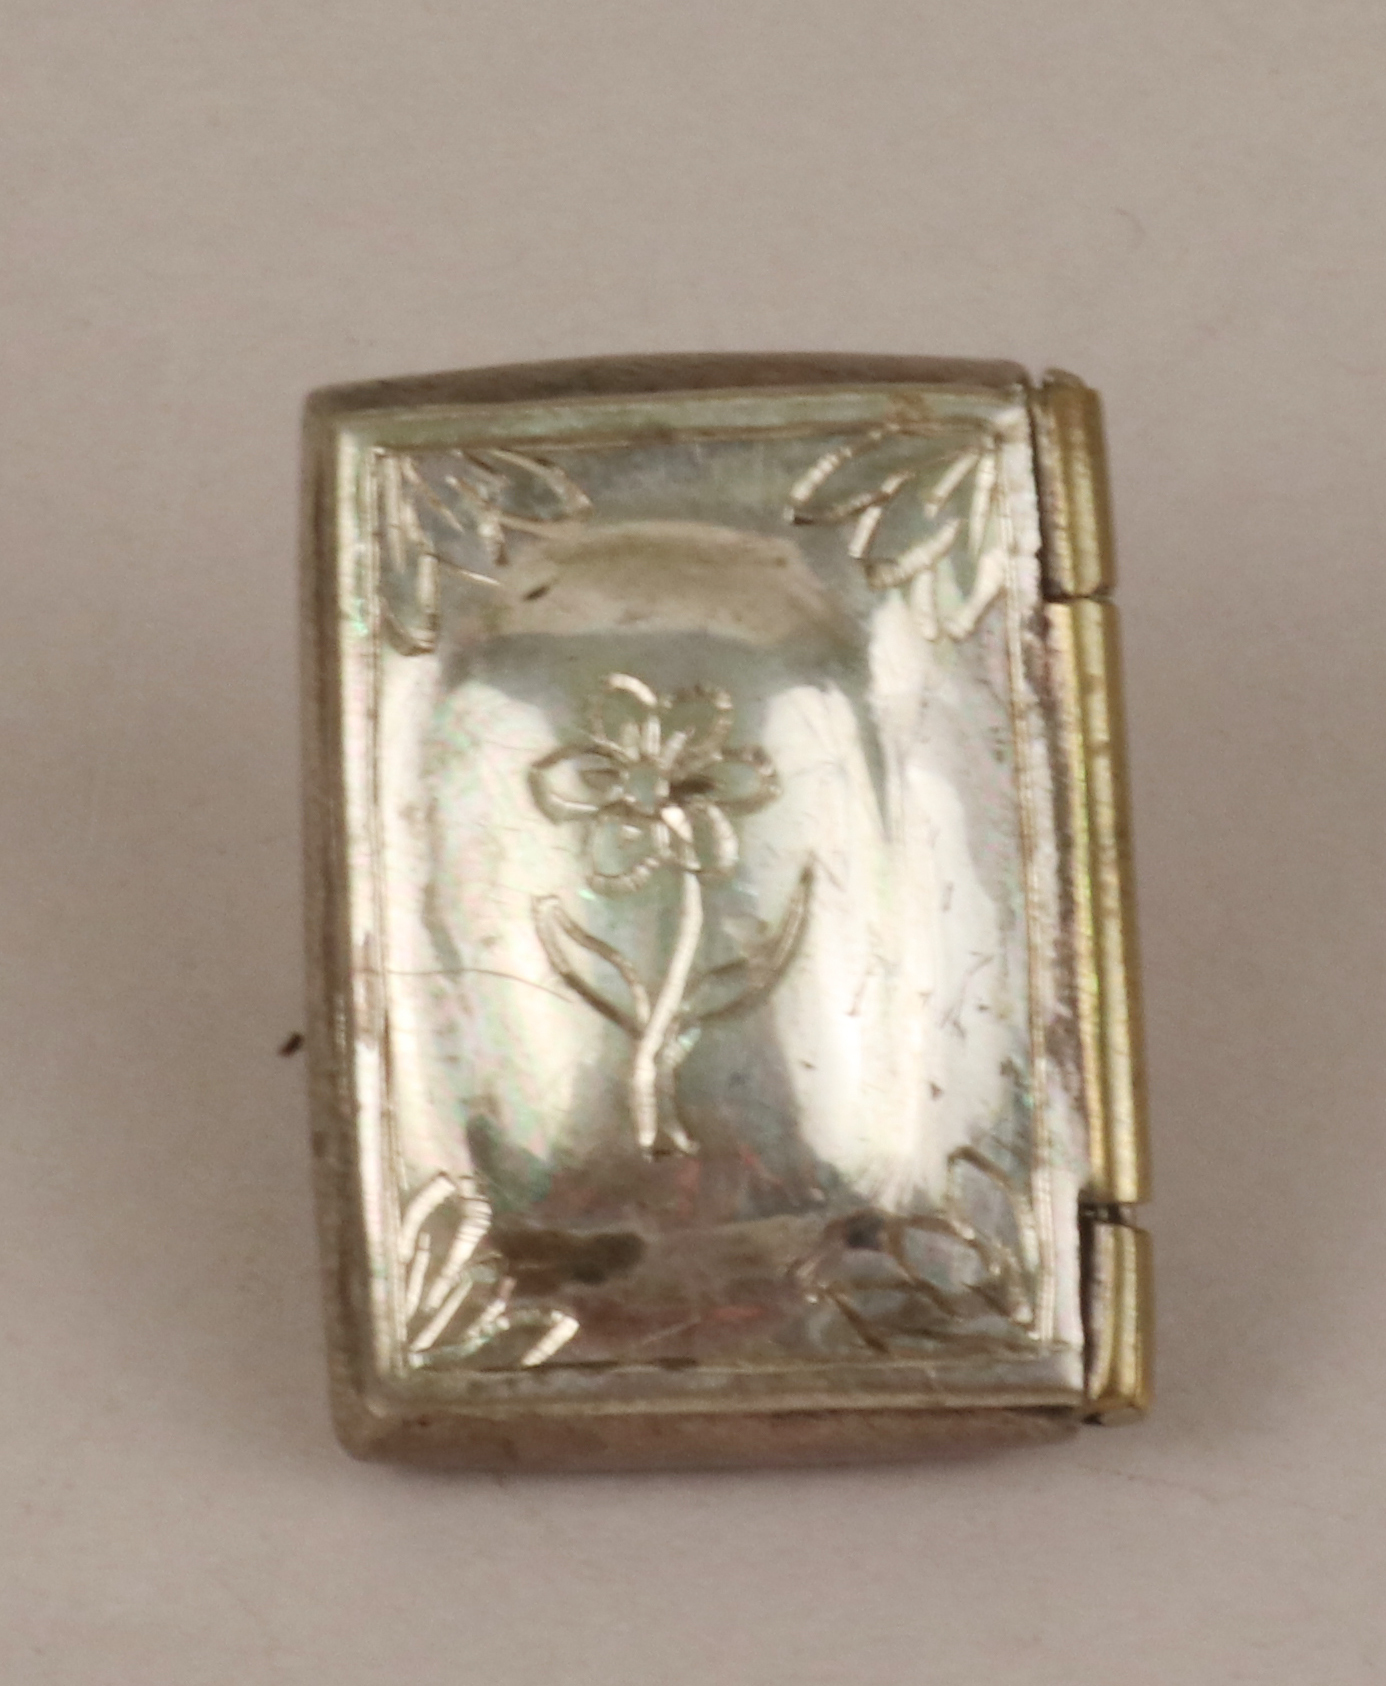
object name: crèche accessory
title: Silver snuffbox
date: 1701-1800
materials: silver